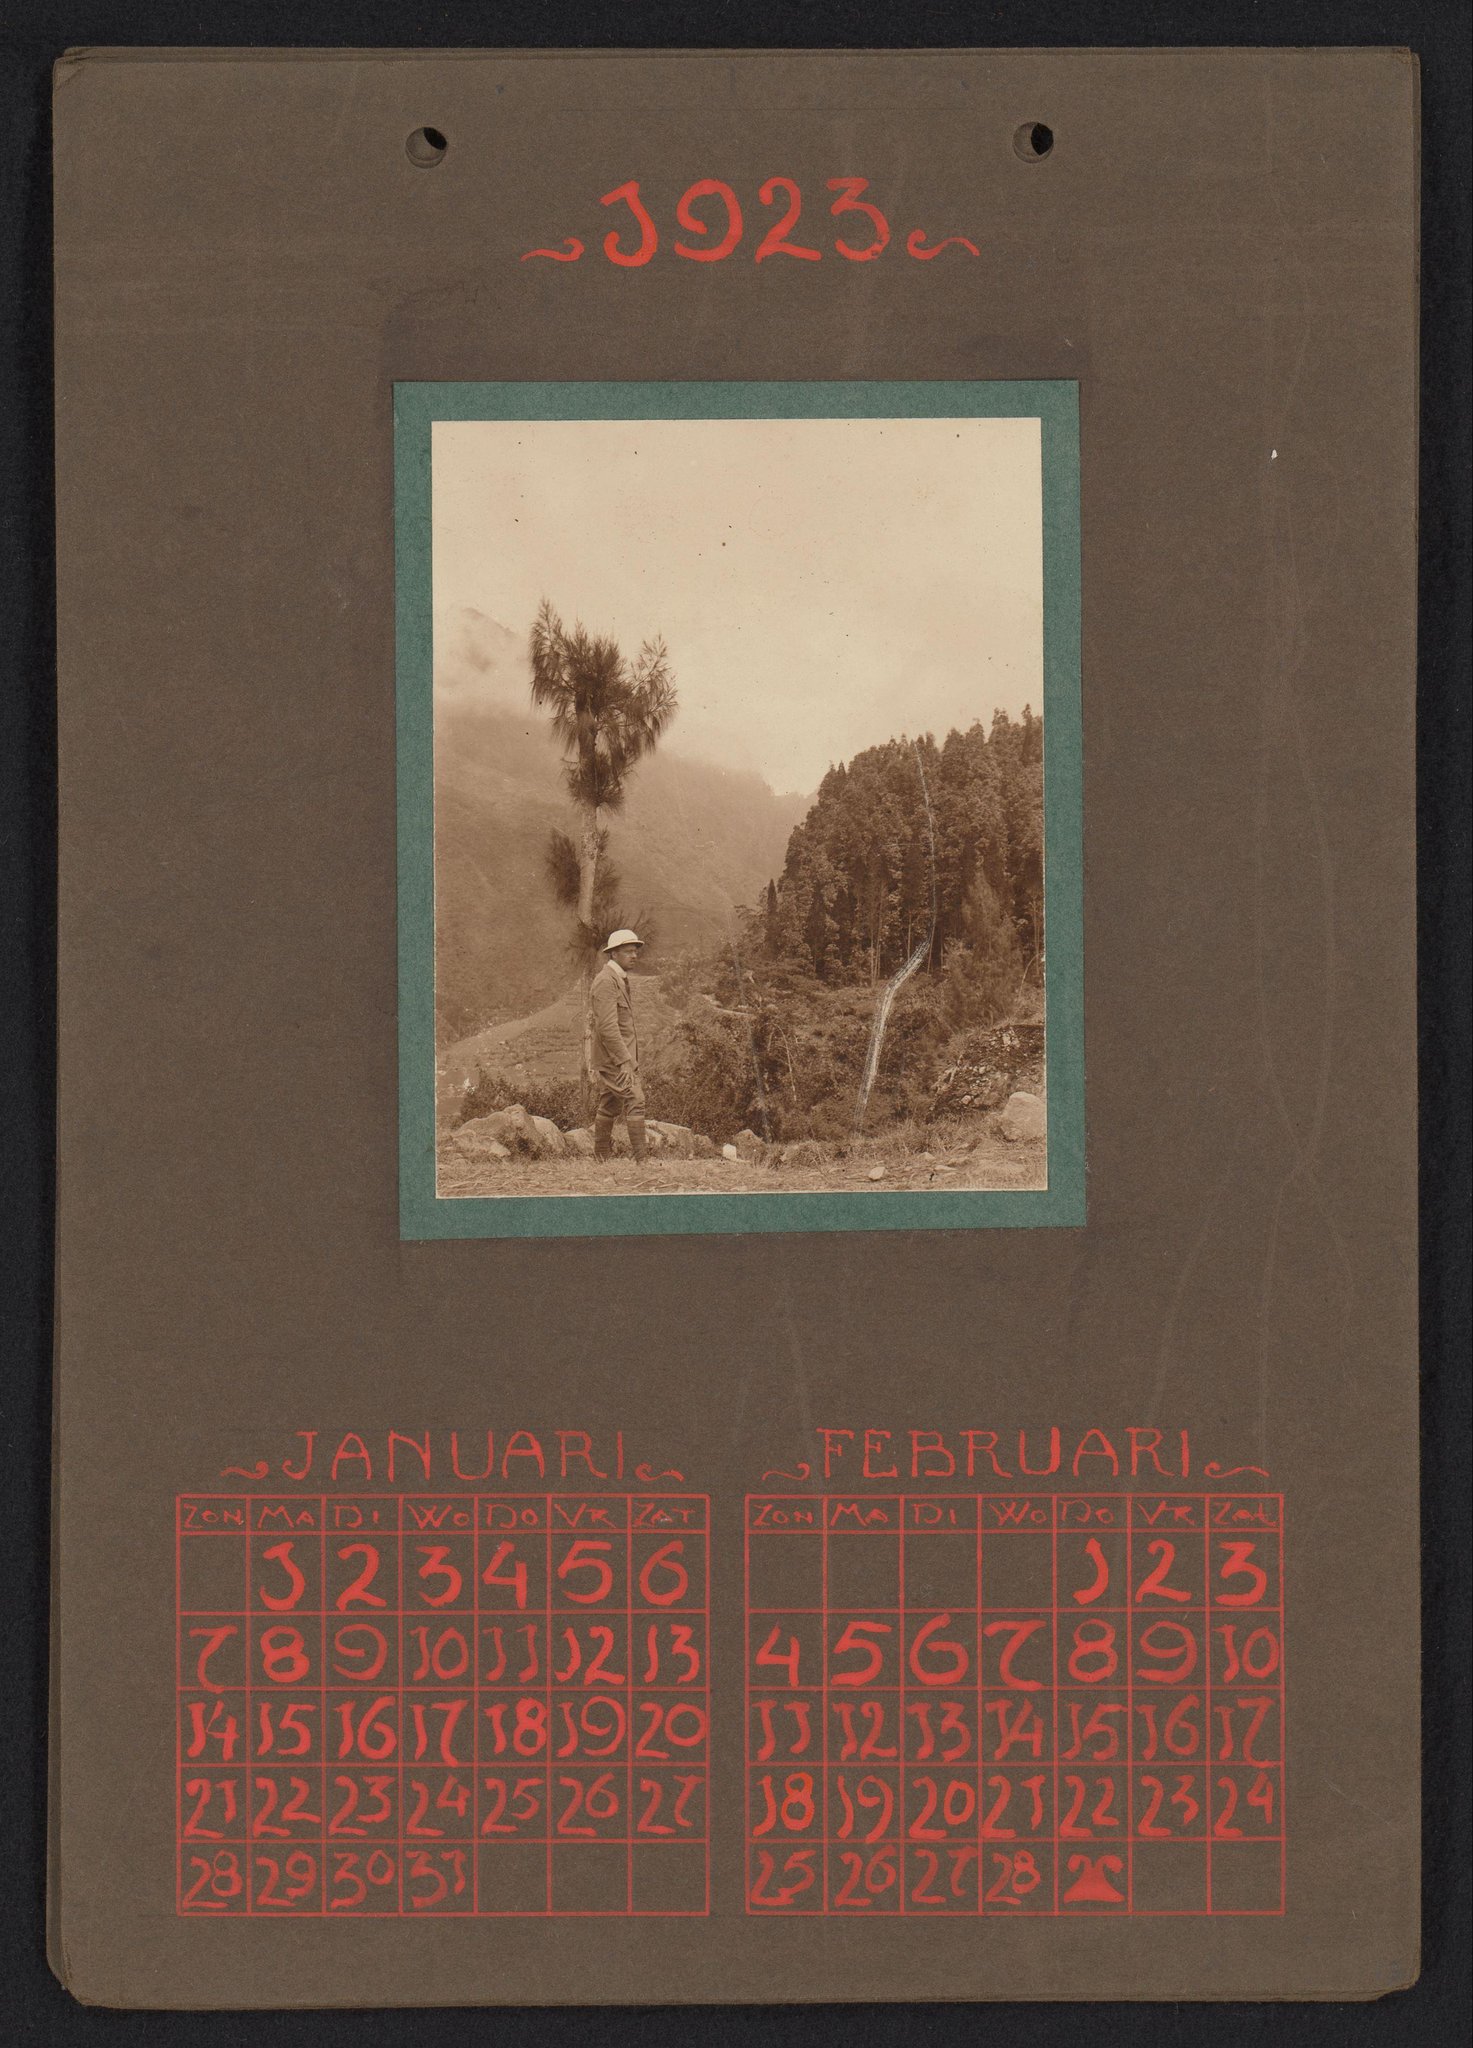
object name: photograph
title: Landschap met bergen, met op de voorgrond een reiziger met hoed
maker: Anonymous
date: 1880-1923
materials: cardboard, paper, photographic support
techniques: collodion silver print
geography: indonesia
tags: gulf, bay, adult man, travelling; tourism, indonesia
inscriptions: annotation: ‘9123/ JANUARI/ (...)/ FEBRUARI/ (...)’